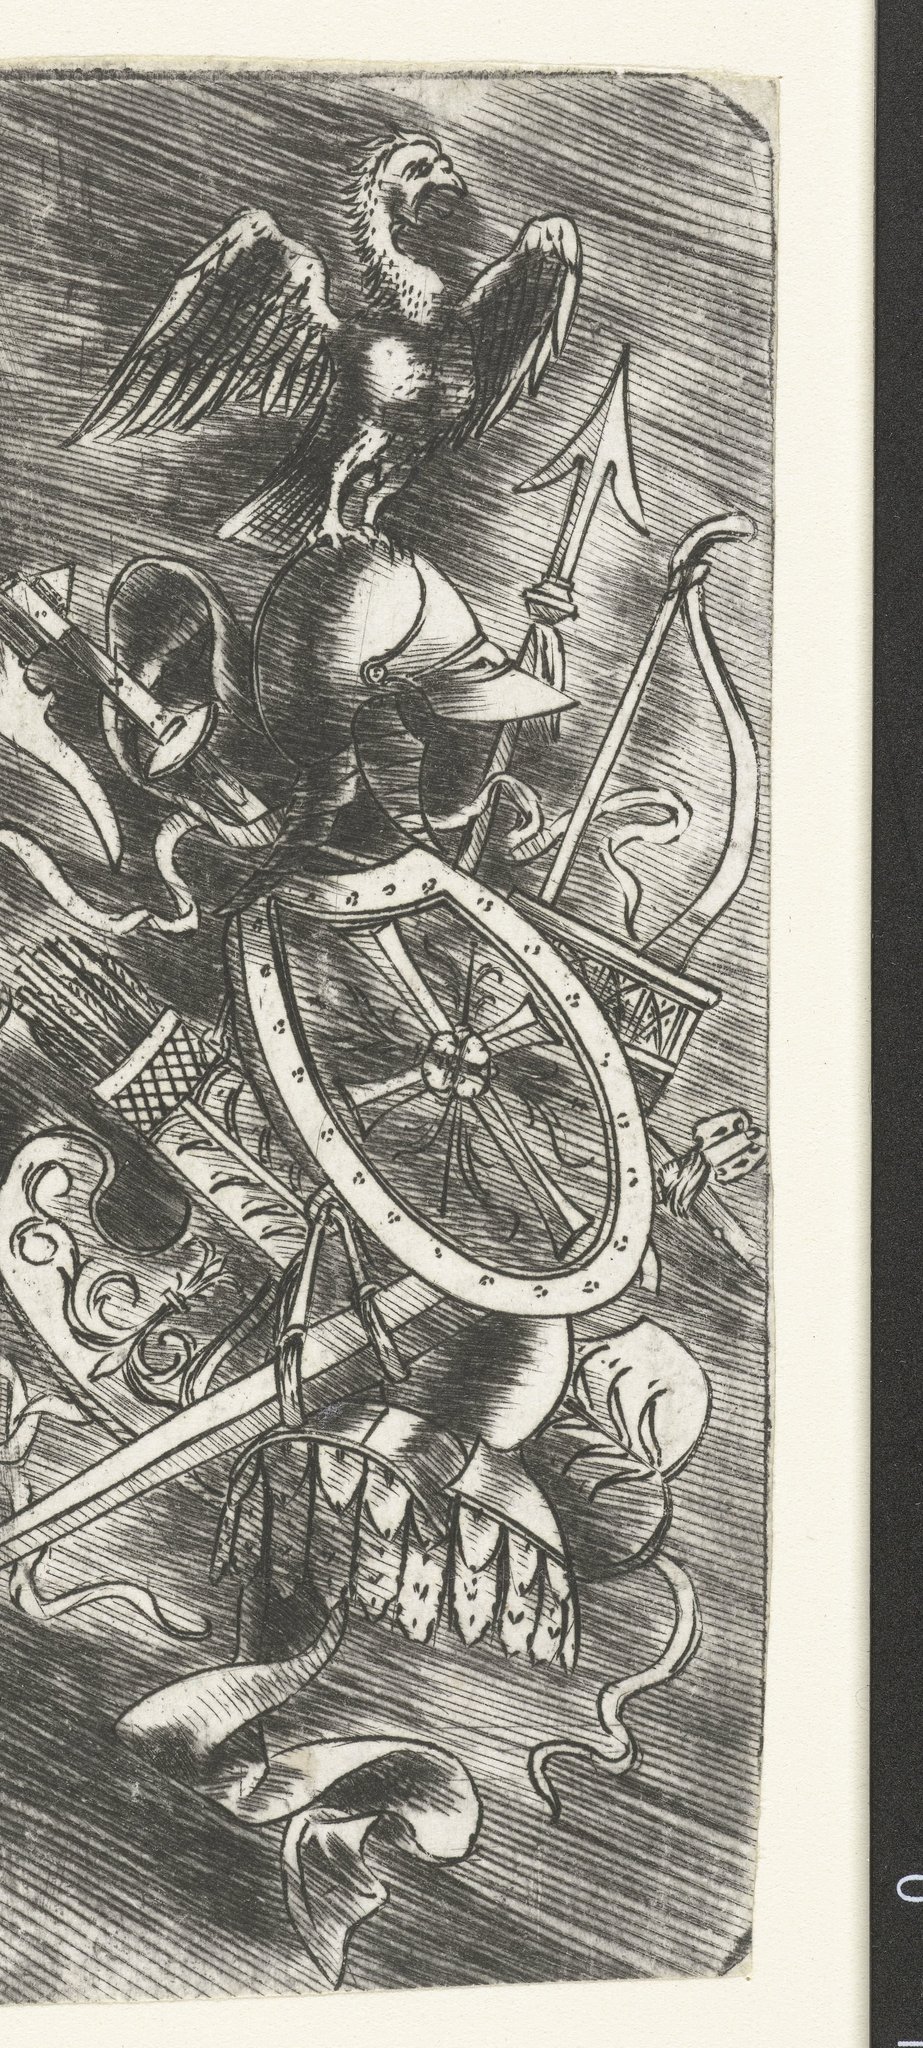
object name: print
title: Adelaar bovenop wapentrofeeën waaronder verschillende wapens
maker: meester van 1515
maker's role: print maker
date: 1500-1548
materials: paper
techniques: drypoint, engraving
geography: italy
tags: trophy ~ battle, war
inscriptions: collector's mark: Lugt 240